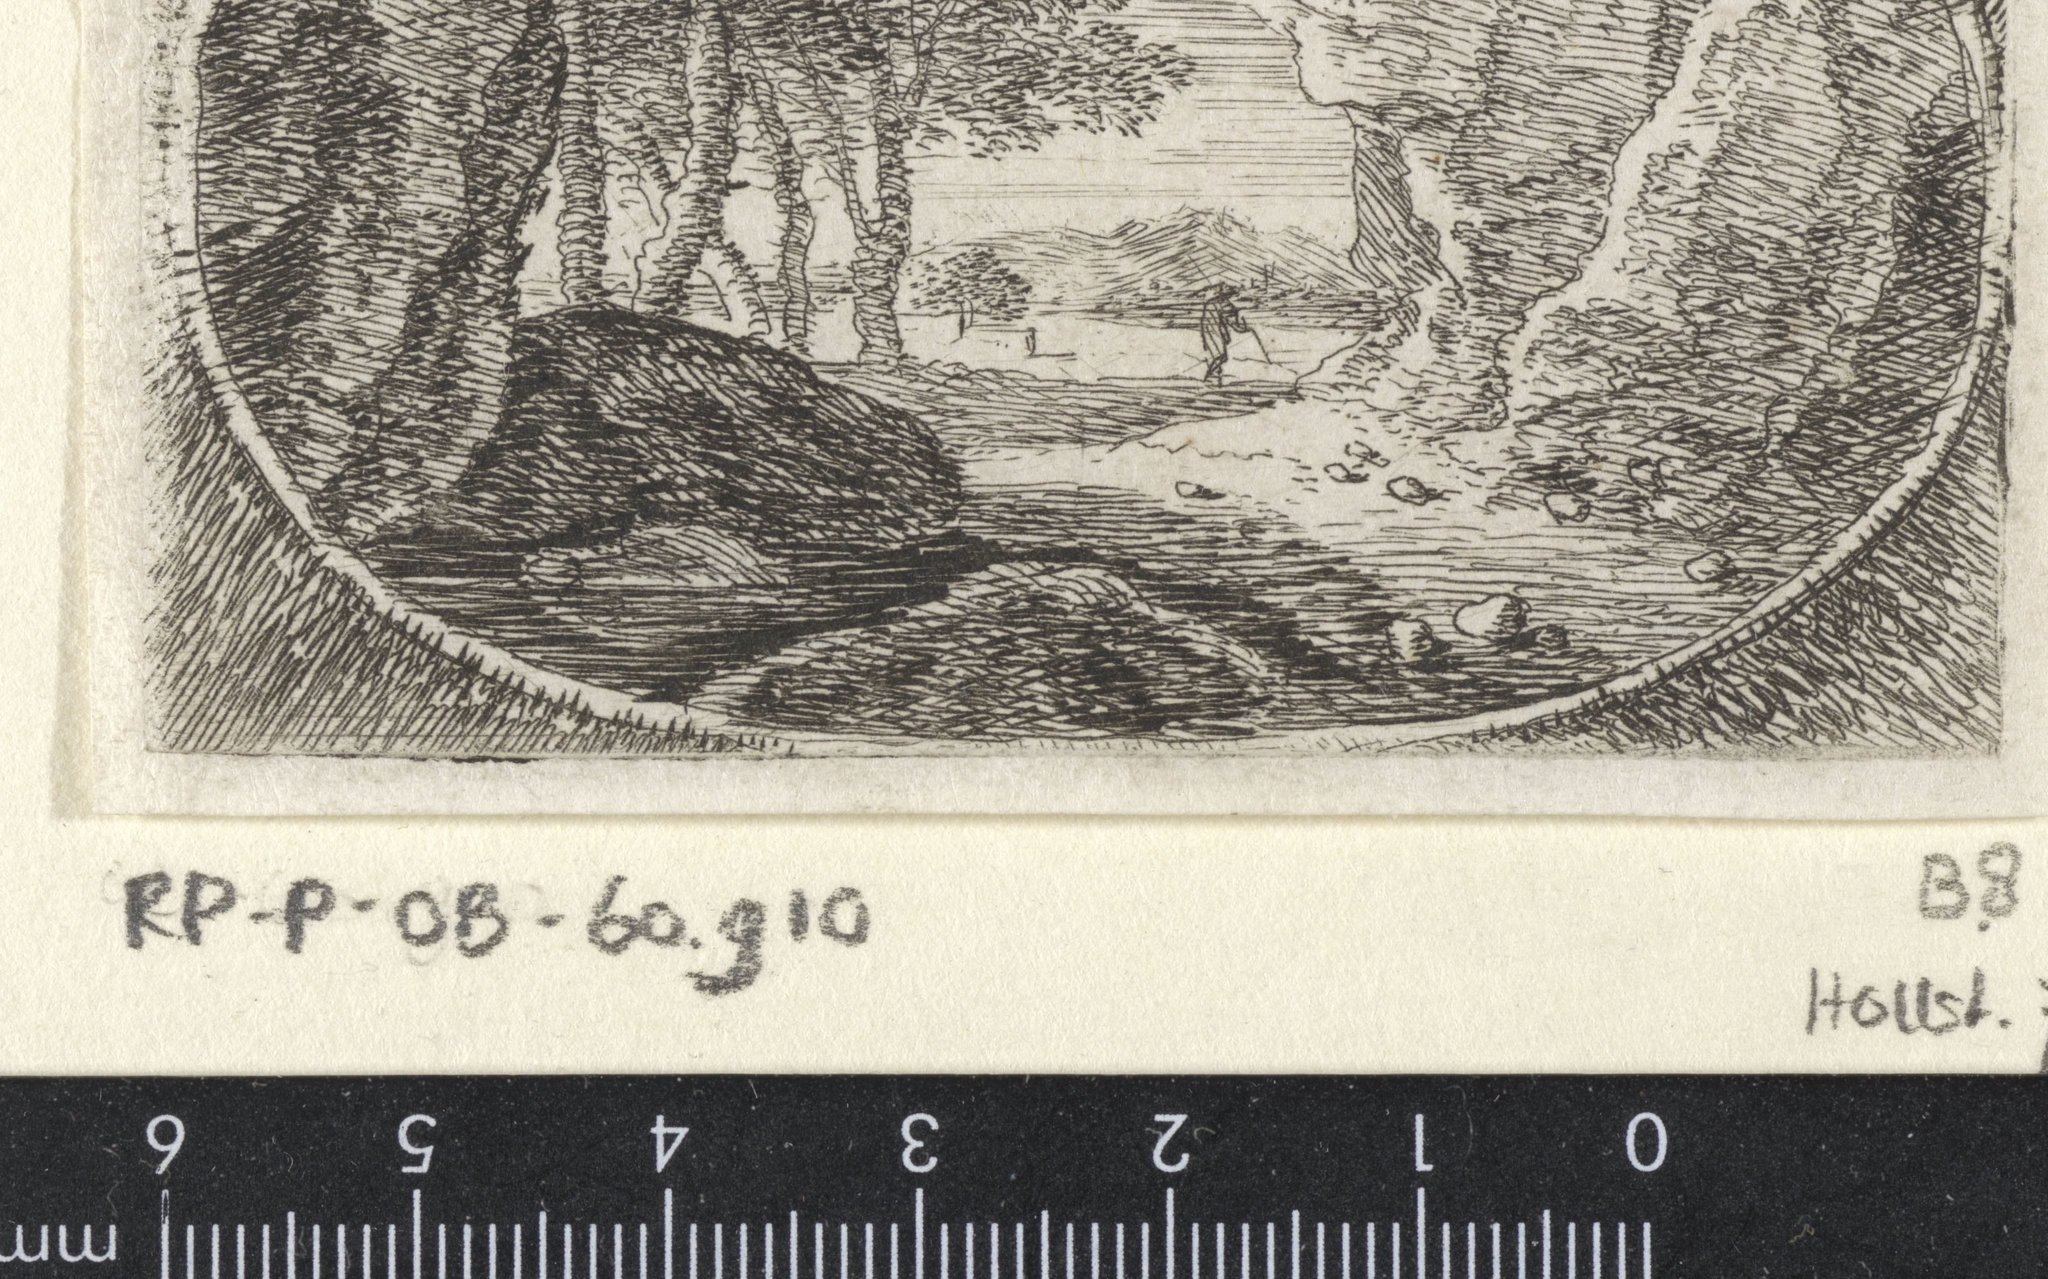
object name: print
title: Ovale fantasielandschappen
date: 1650-1655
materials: paper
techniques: etching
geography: paris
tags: landscapes, (high) hill, 'en route', traveller under way, rocks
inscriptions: collector's mark: Lugt 240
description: In een ovale omlijsting loopt een wandelaar op een pad langs een grote rotspartij.